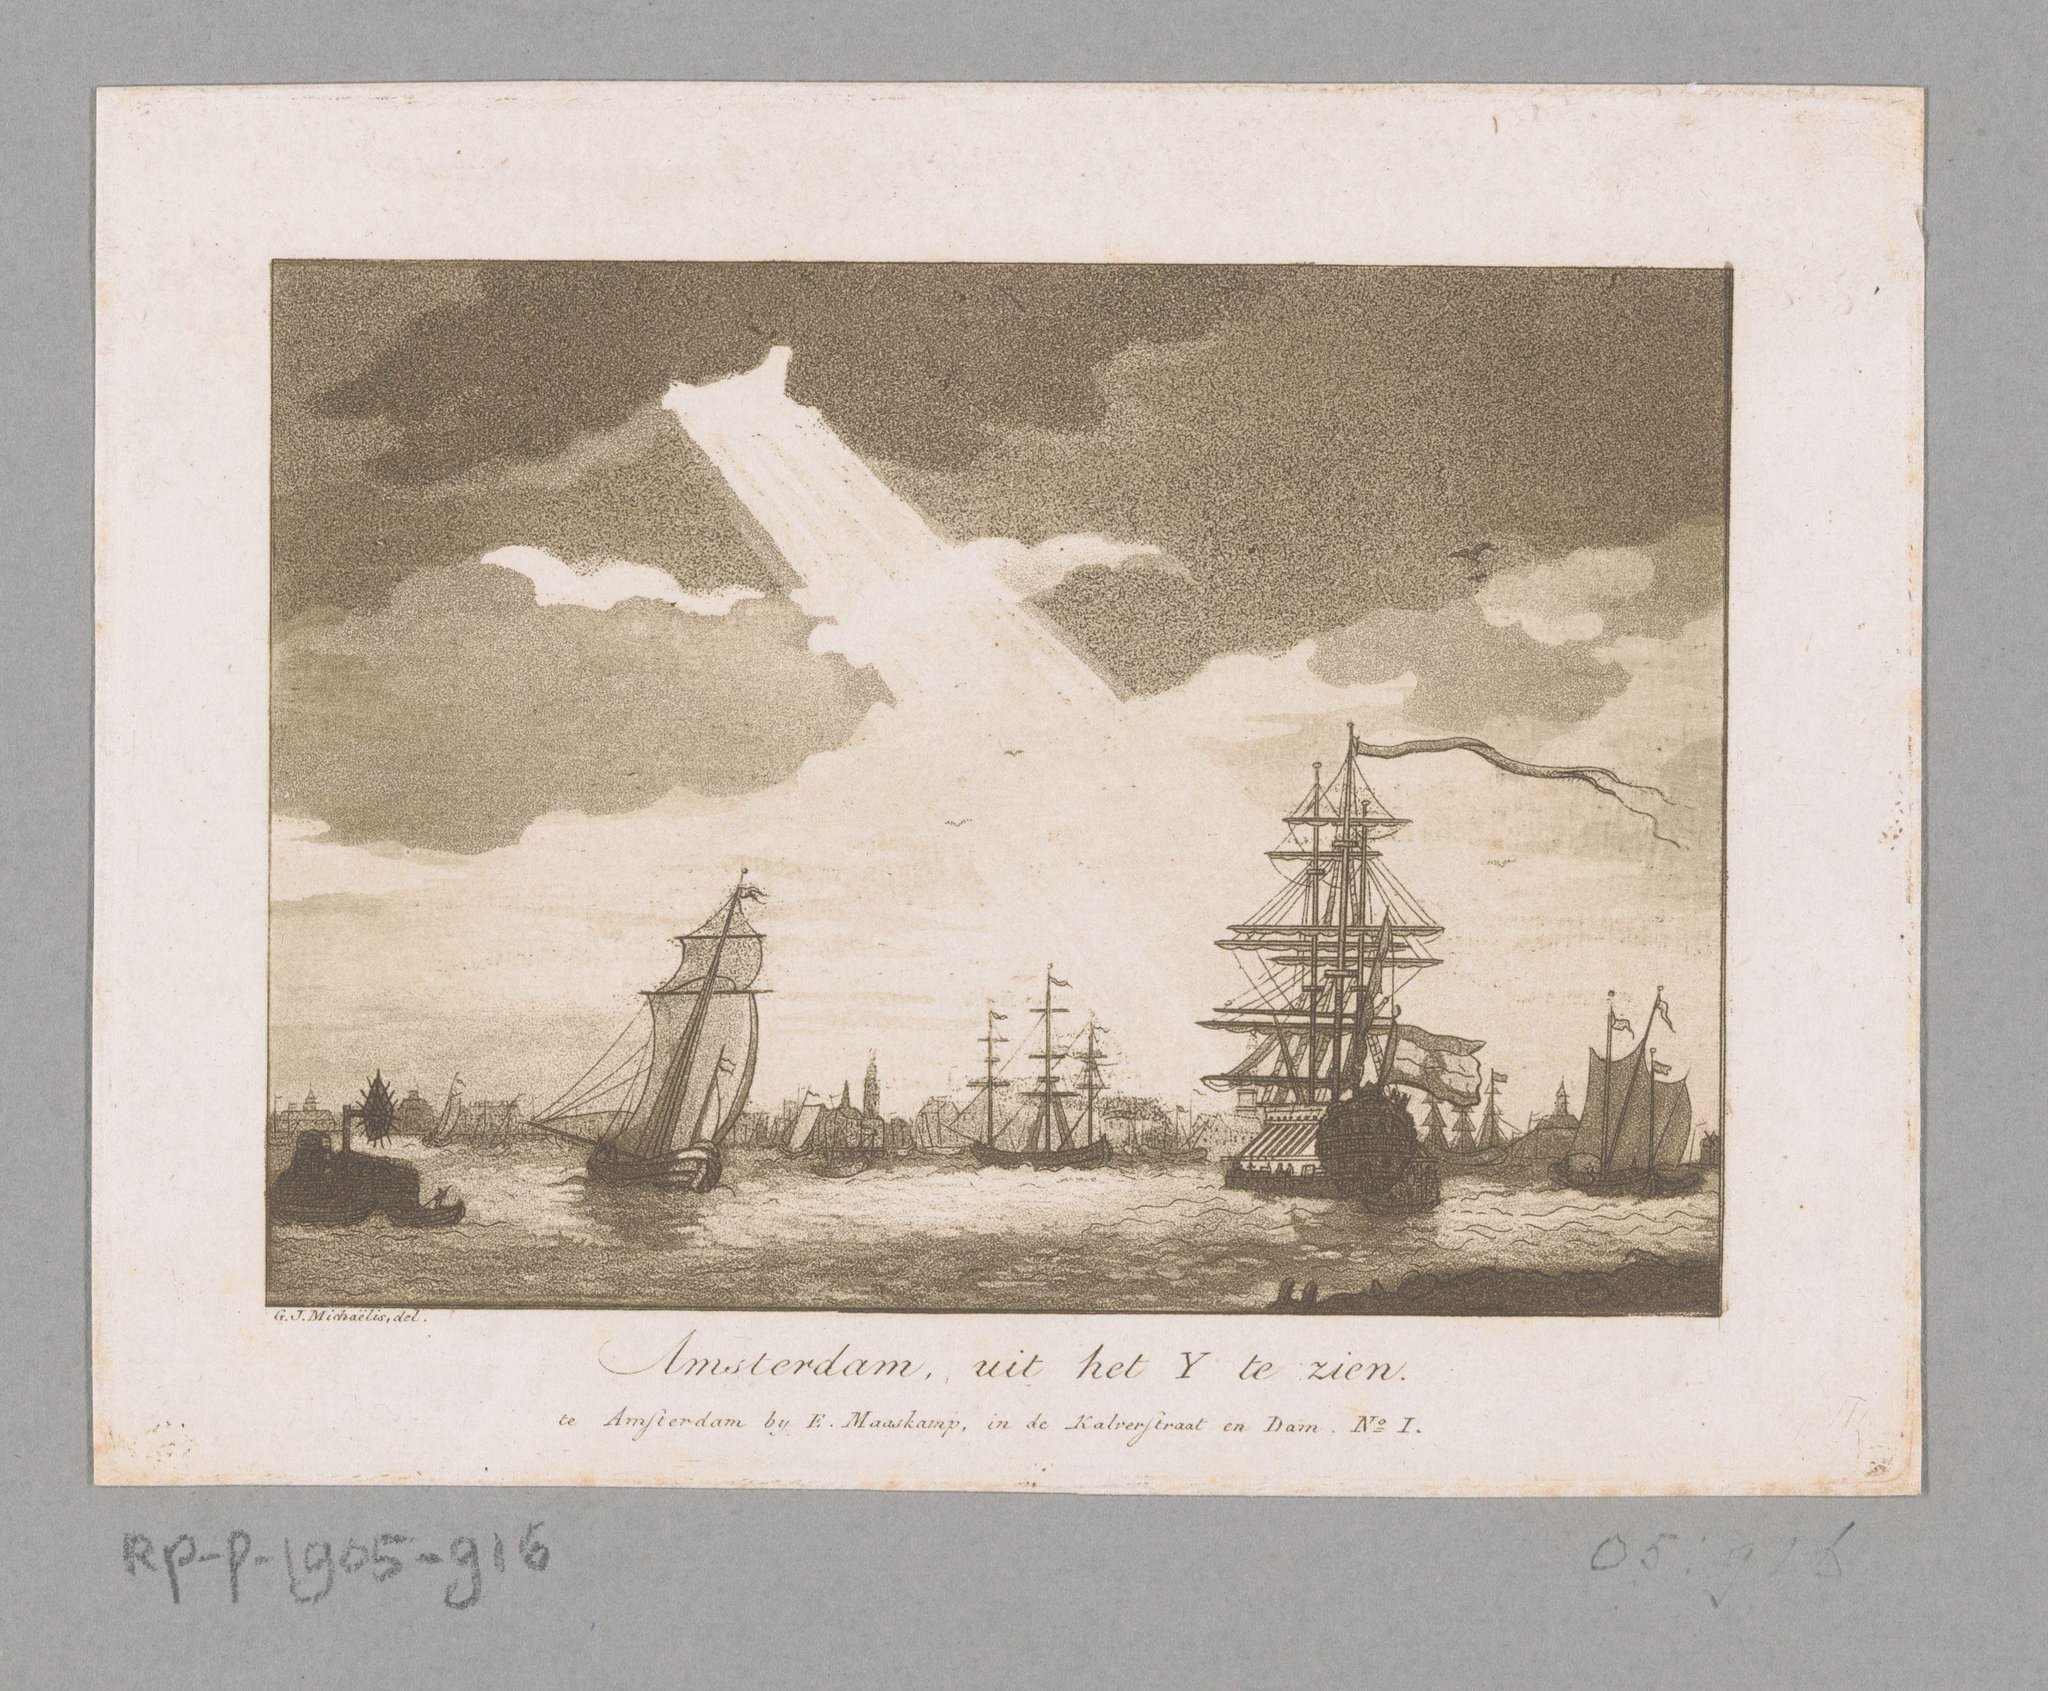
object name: book illustration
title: Amsterdam, uit het IJ te zien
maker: evert maaskamp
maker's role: draughtsman, painter, print maker, publisher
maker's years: 1769-1834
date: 1812-1813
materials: paper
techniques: aquatint, etching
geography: amsterdam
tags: city-view, and landscape with man-made constructions, ships (in general) - cc - more than one ship, amsterdam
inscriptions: collector's mark: Lugt 2228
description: Prent uit: Reis door Holland in de jaren 1807 - 1812. Amsterdam: E. Maaskamp, [1812-1813].